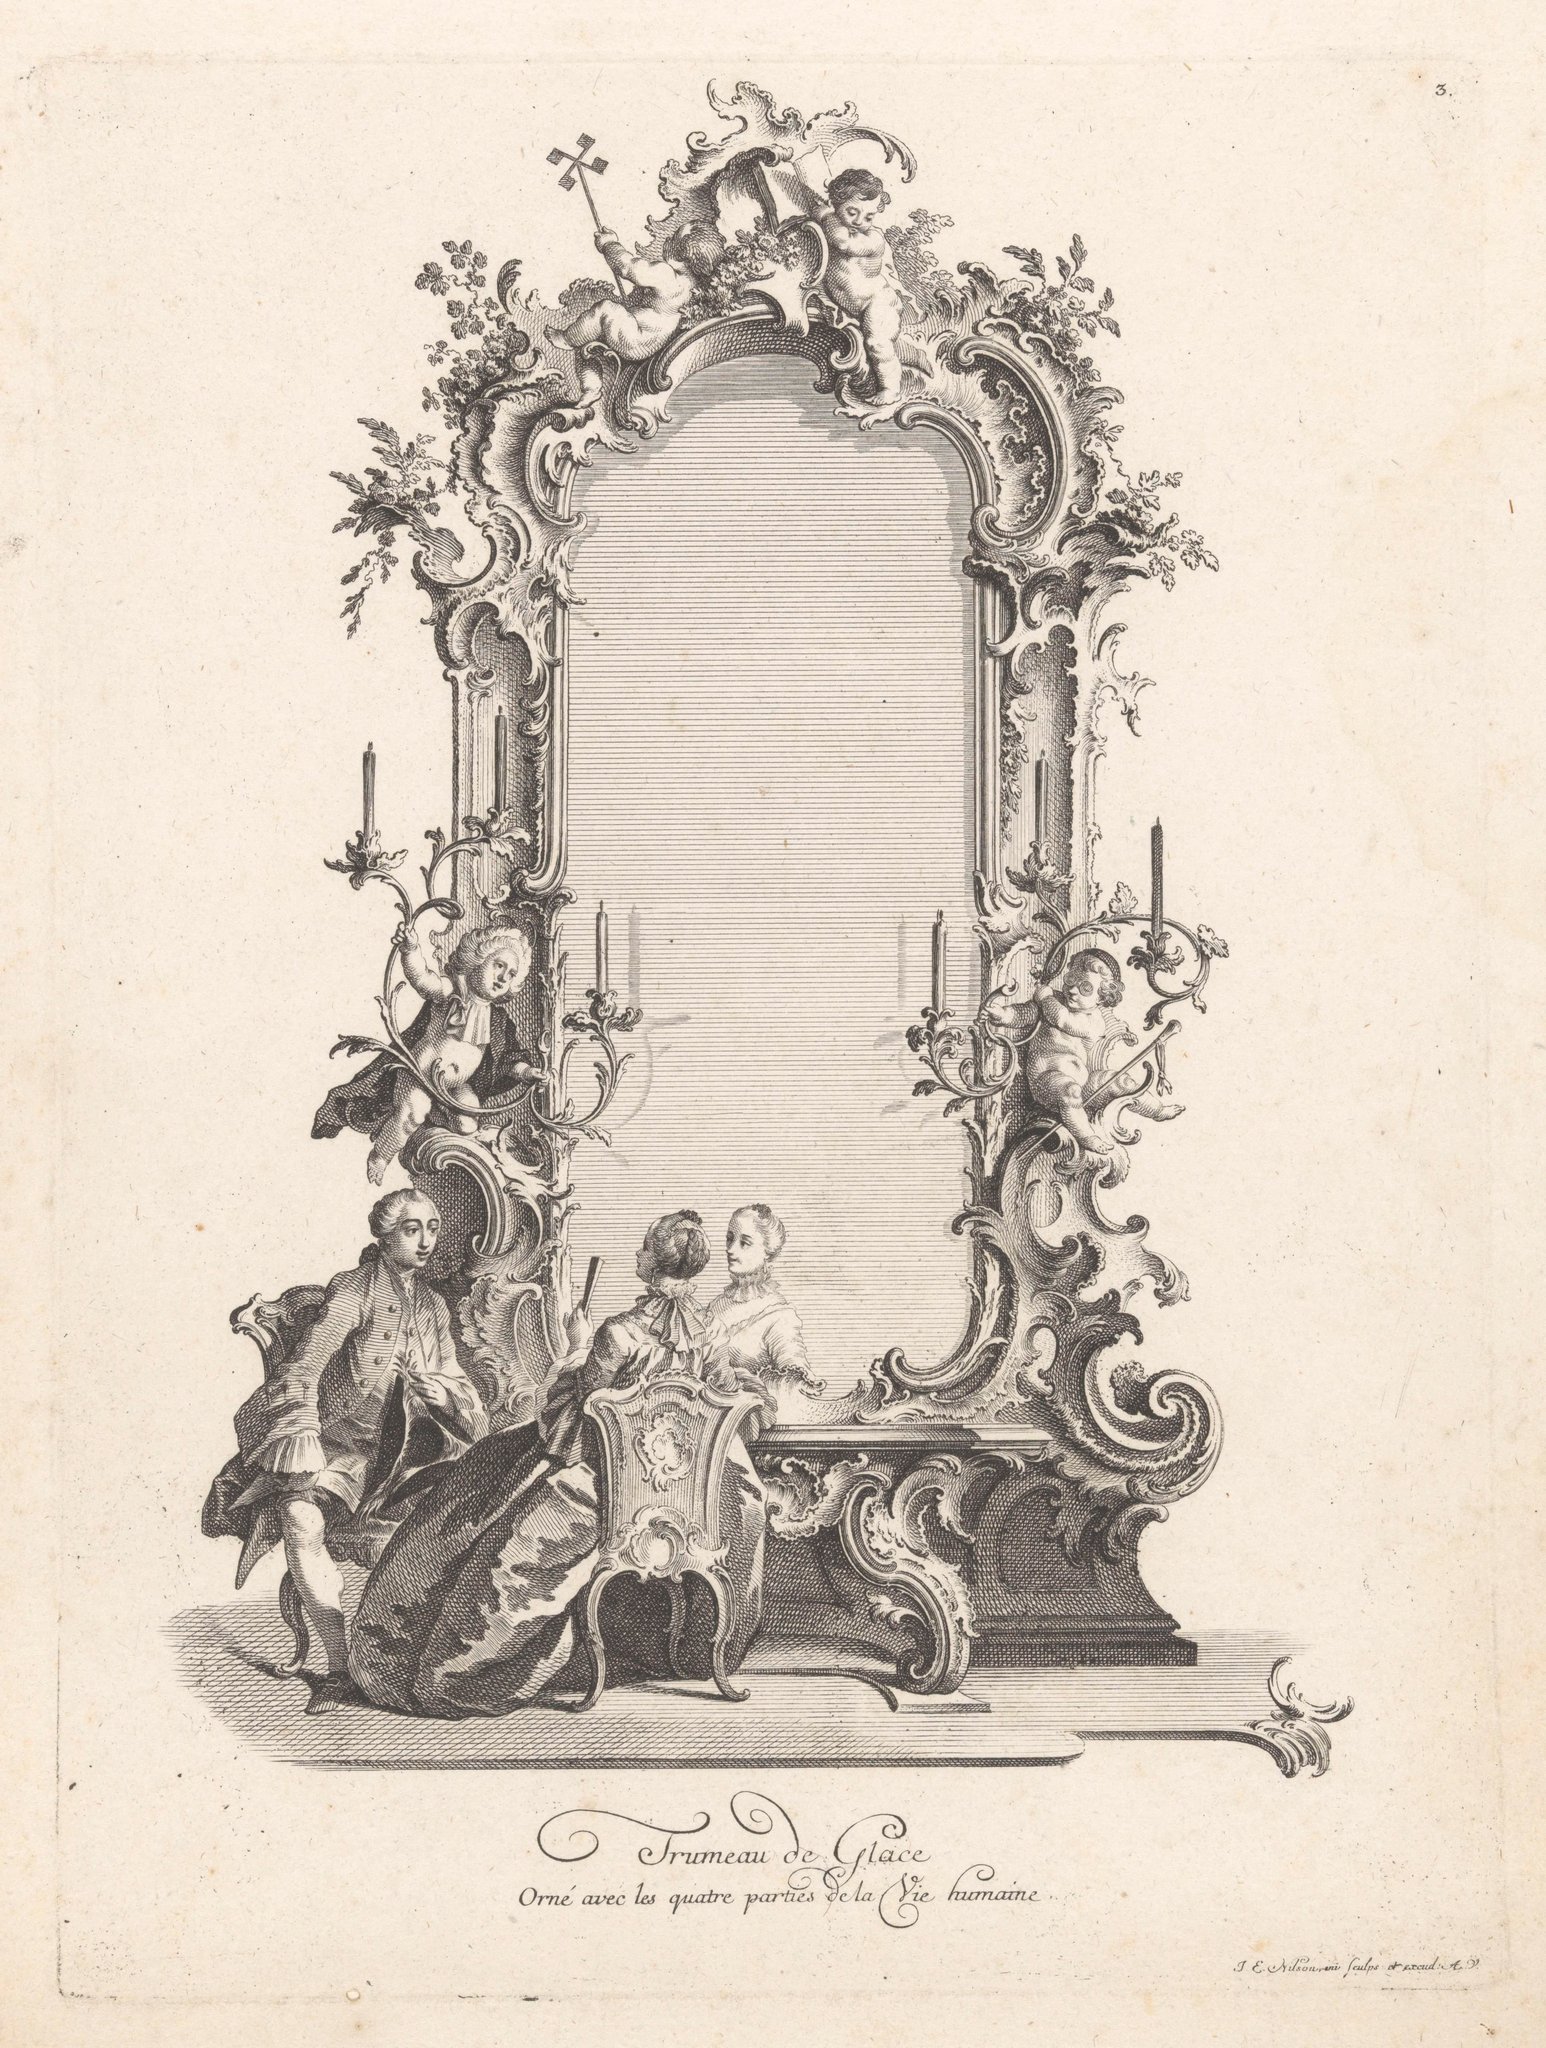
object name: print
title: Trumeau de Glace (...)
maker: johann esaias nilson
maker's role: draughtsman, print maker, publisher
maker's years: 1721-1788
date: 1731-1788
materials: paper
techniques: engraving, etching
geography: augsburg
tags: the ages of man, mirror, cupids: 'amores', 'amoretti', 'putti'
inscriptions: collector's mark: Lugt 2228, collector's mark: Lugt 2760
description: Voor een spiegel met rocaille ornamenten, twee driearmige kandelaars en putti zitten een man en een vrouw op stoelen. De vier putti op de spiegellijst symboliseren vier leeftijdsfasen: de putti boven staan symbool voor de kinderjaren en jeugd, de putto links onder voor de volwassenheid en de putto rechts onder symboliseert de ouderdom.